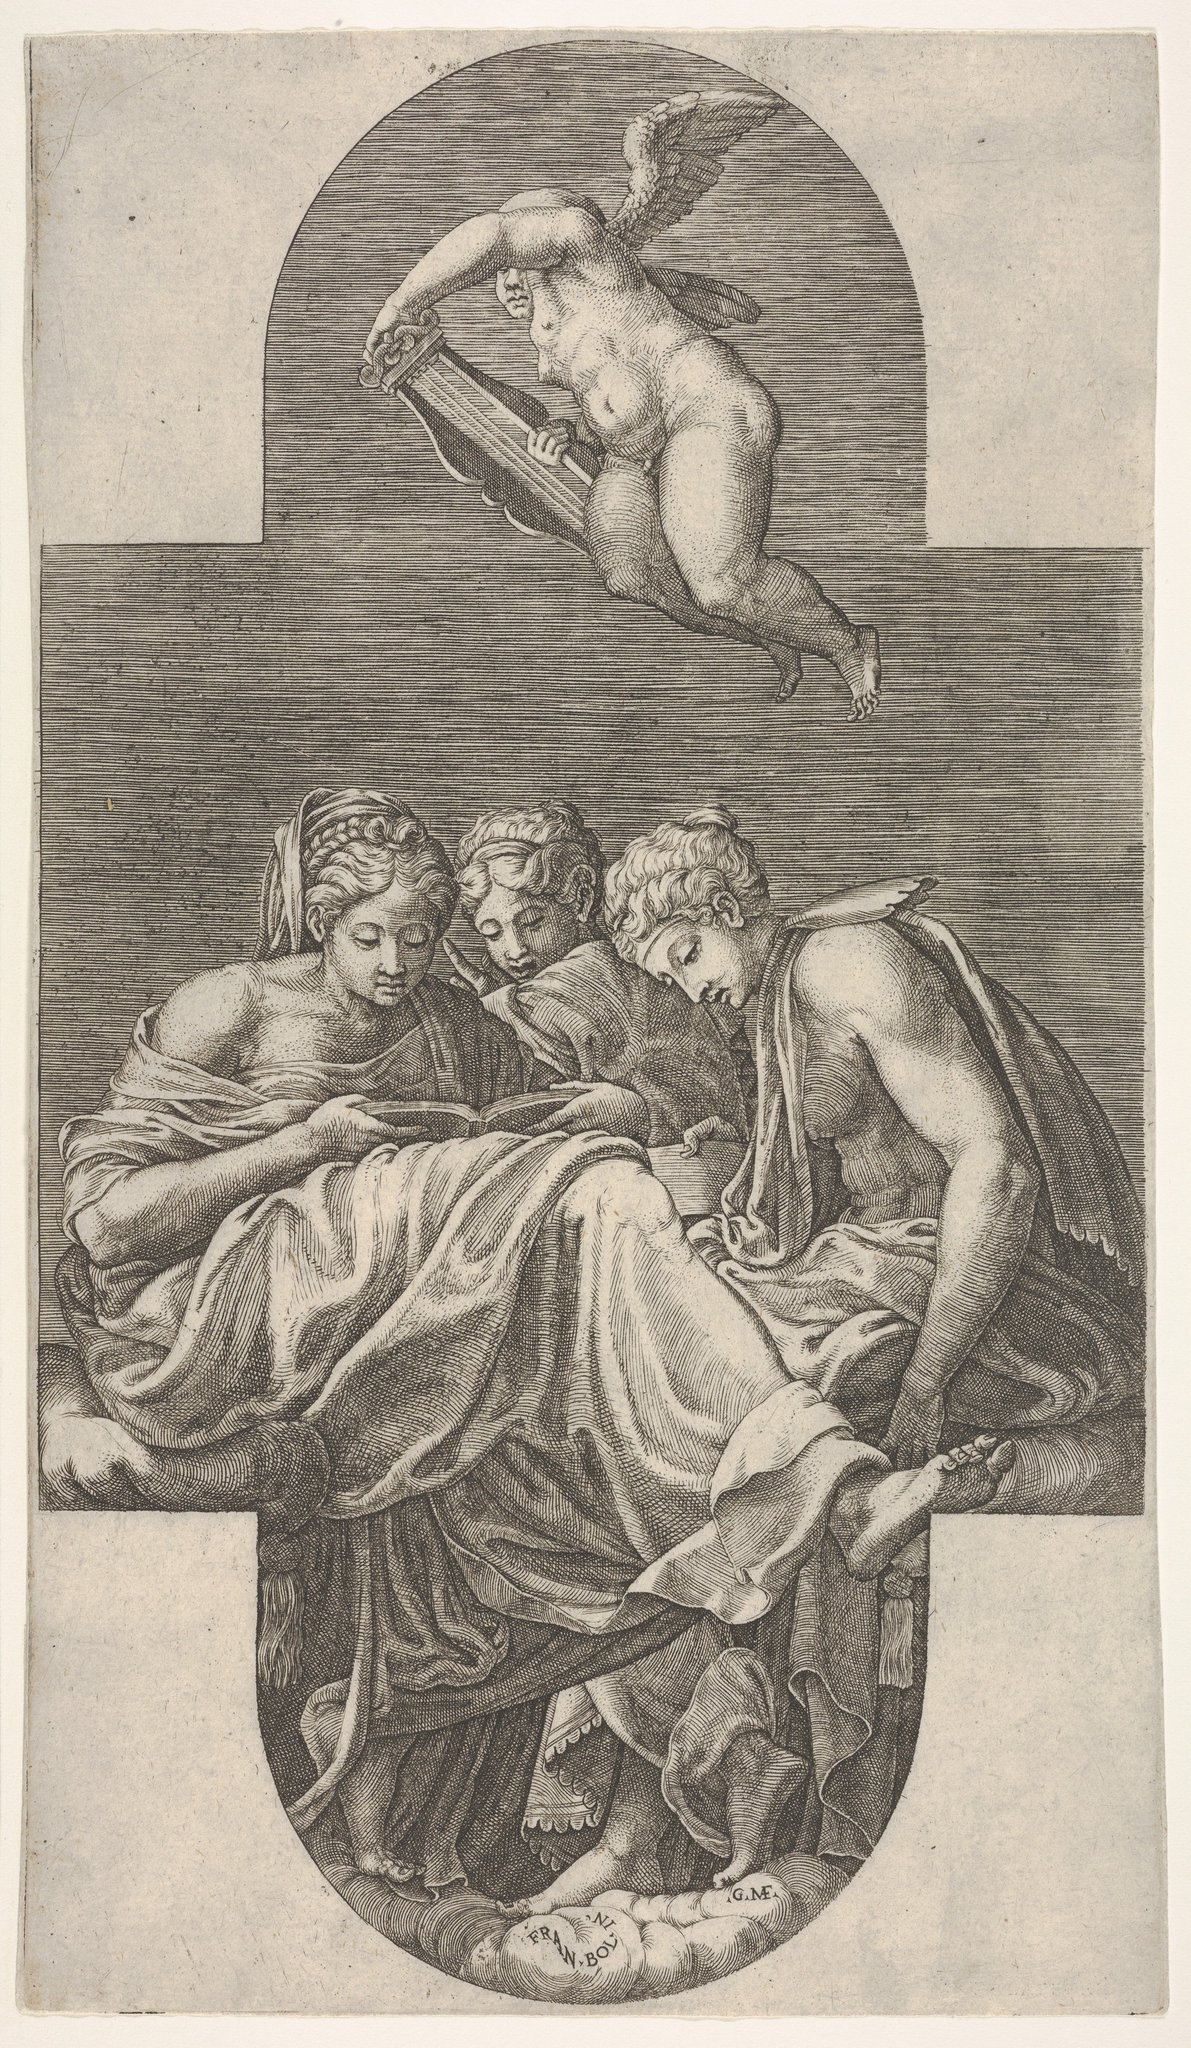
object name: print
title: Three Muses seated below a flying putto who grasps a lyre with both hands, a cruciform composition, from a series of eight compositions after Francesco Primaticcio's designs for the ceiling of the Gallery of Ulysses (destroyed 1738-39) at Fontainebleau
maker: giorgio ghisi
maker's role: artist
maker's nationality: italian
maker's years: 1515-1582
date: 1560-1569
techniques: engraving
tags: musical instruments,reading,muses